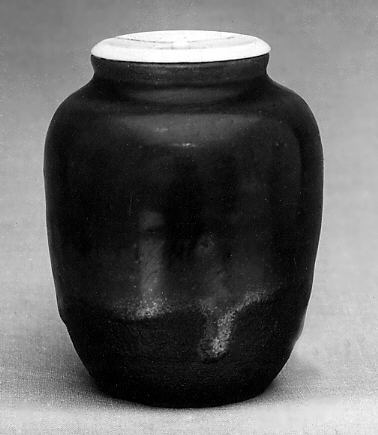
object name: tea jar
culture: japanese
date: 1701-1800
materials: clay, glaze